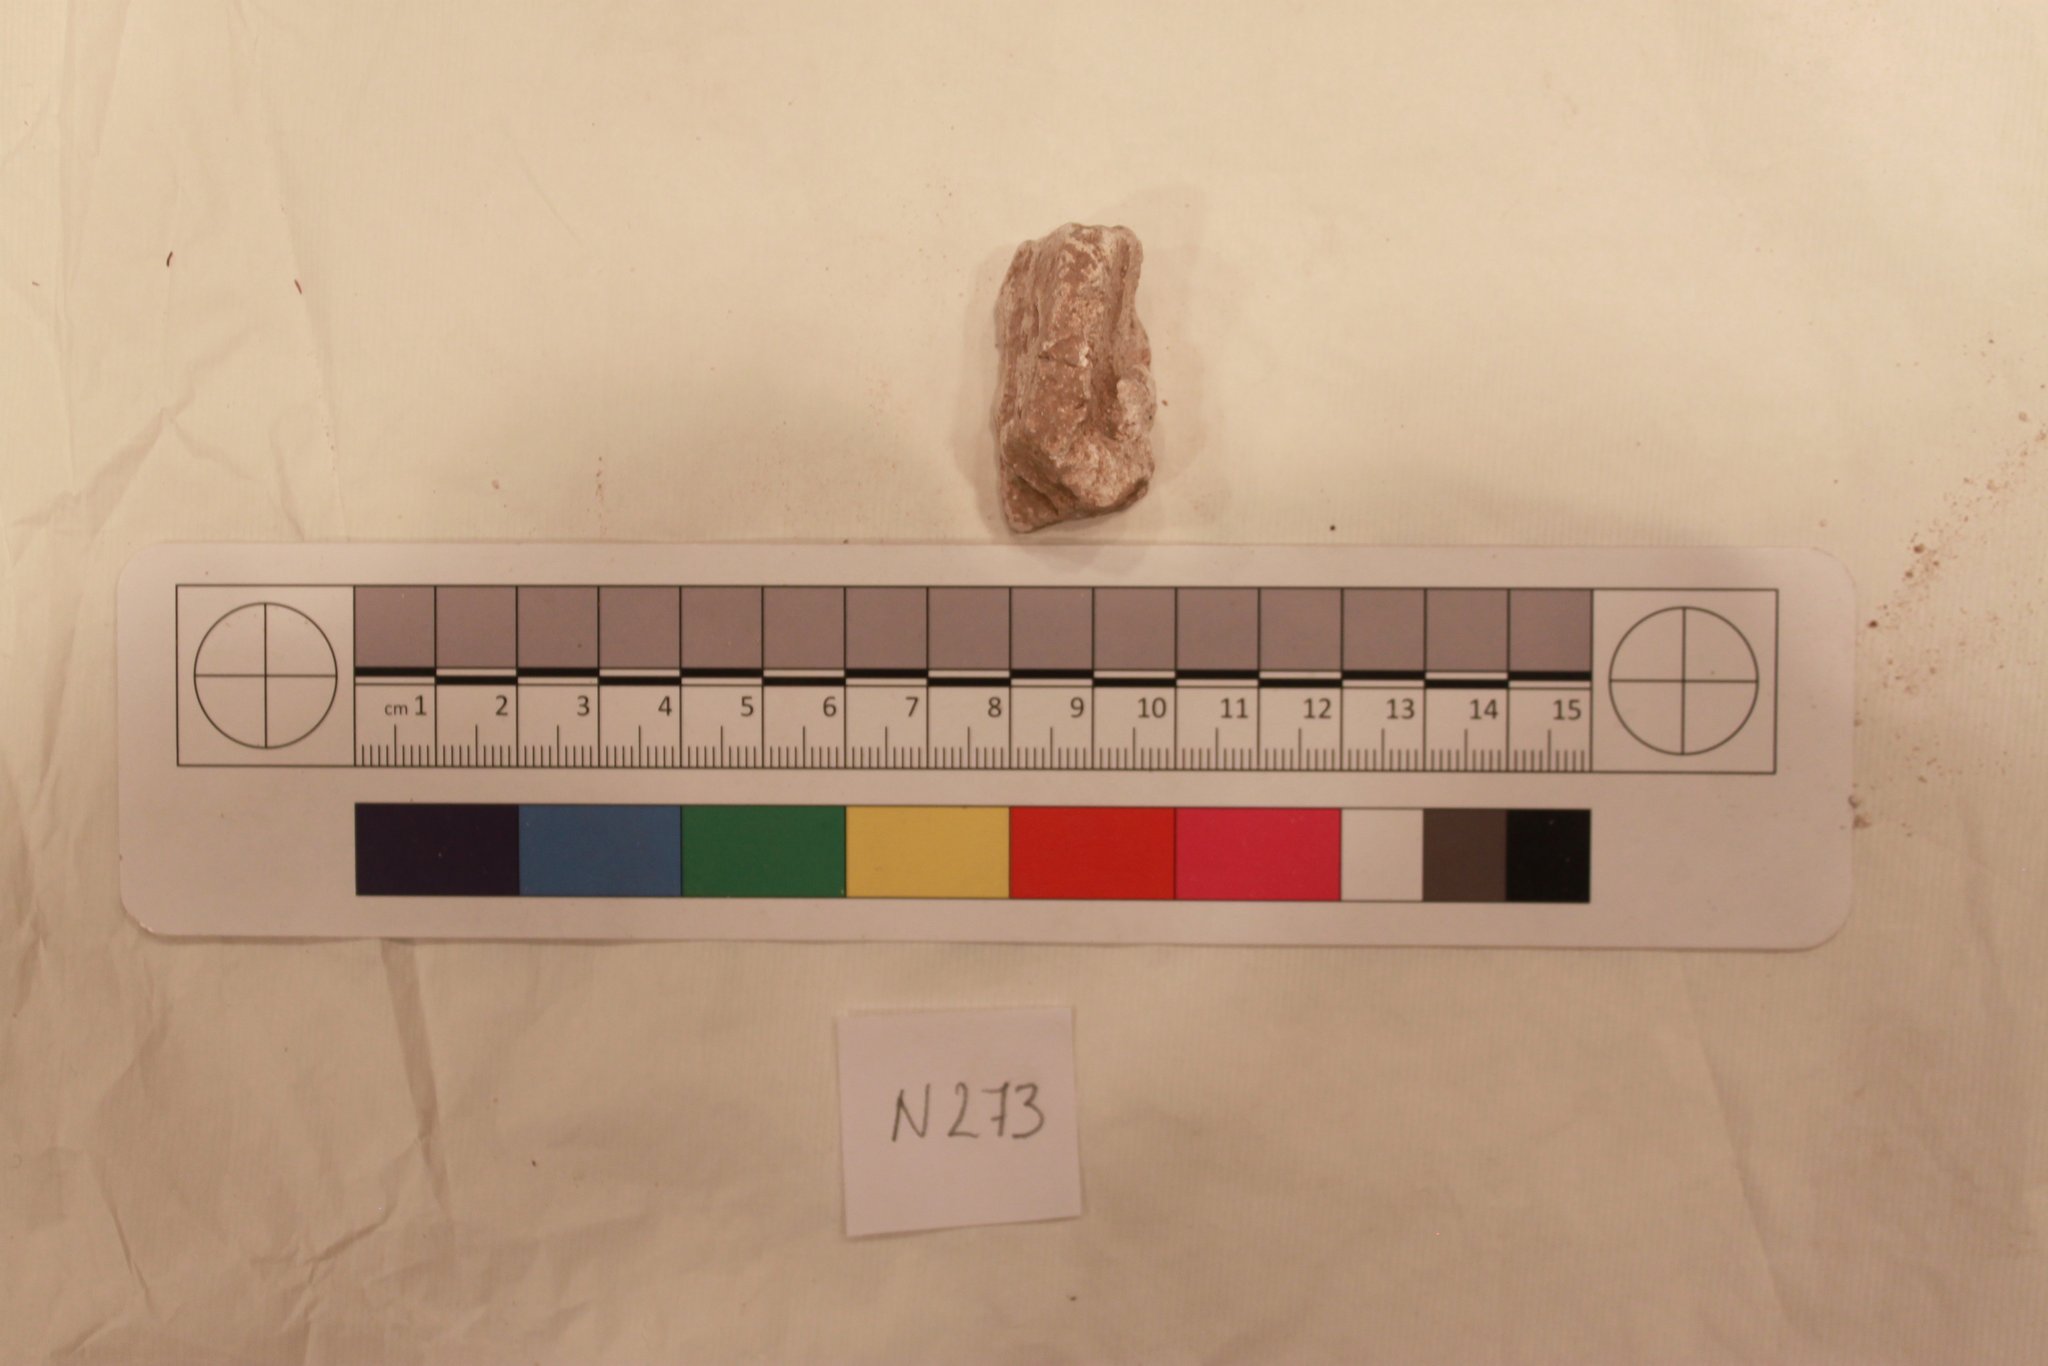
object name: fragment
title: Stucco Fragment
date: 701-1200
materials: plaster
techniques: carving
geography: iran